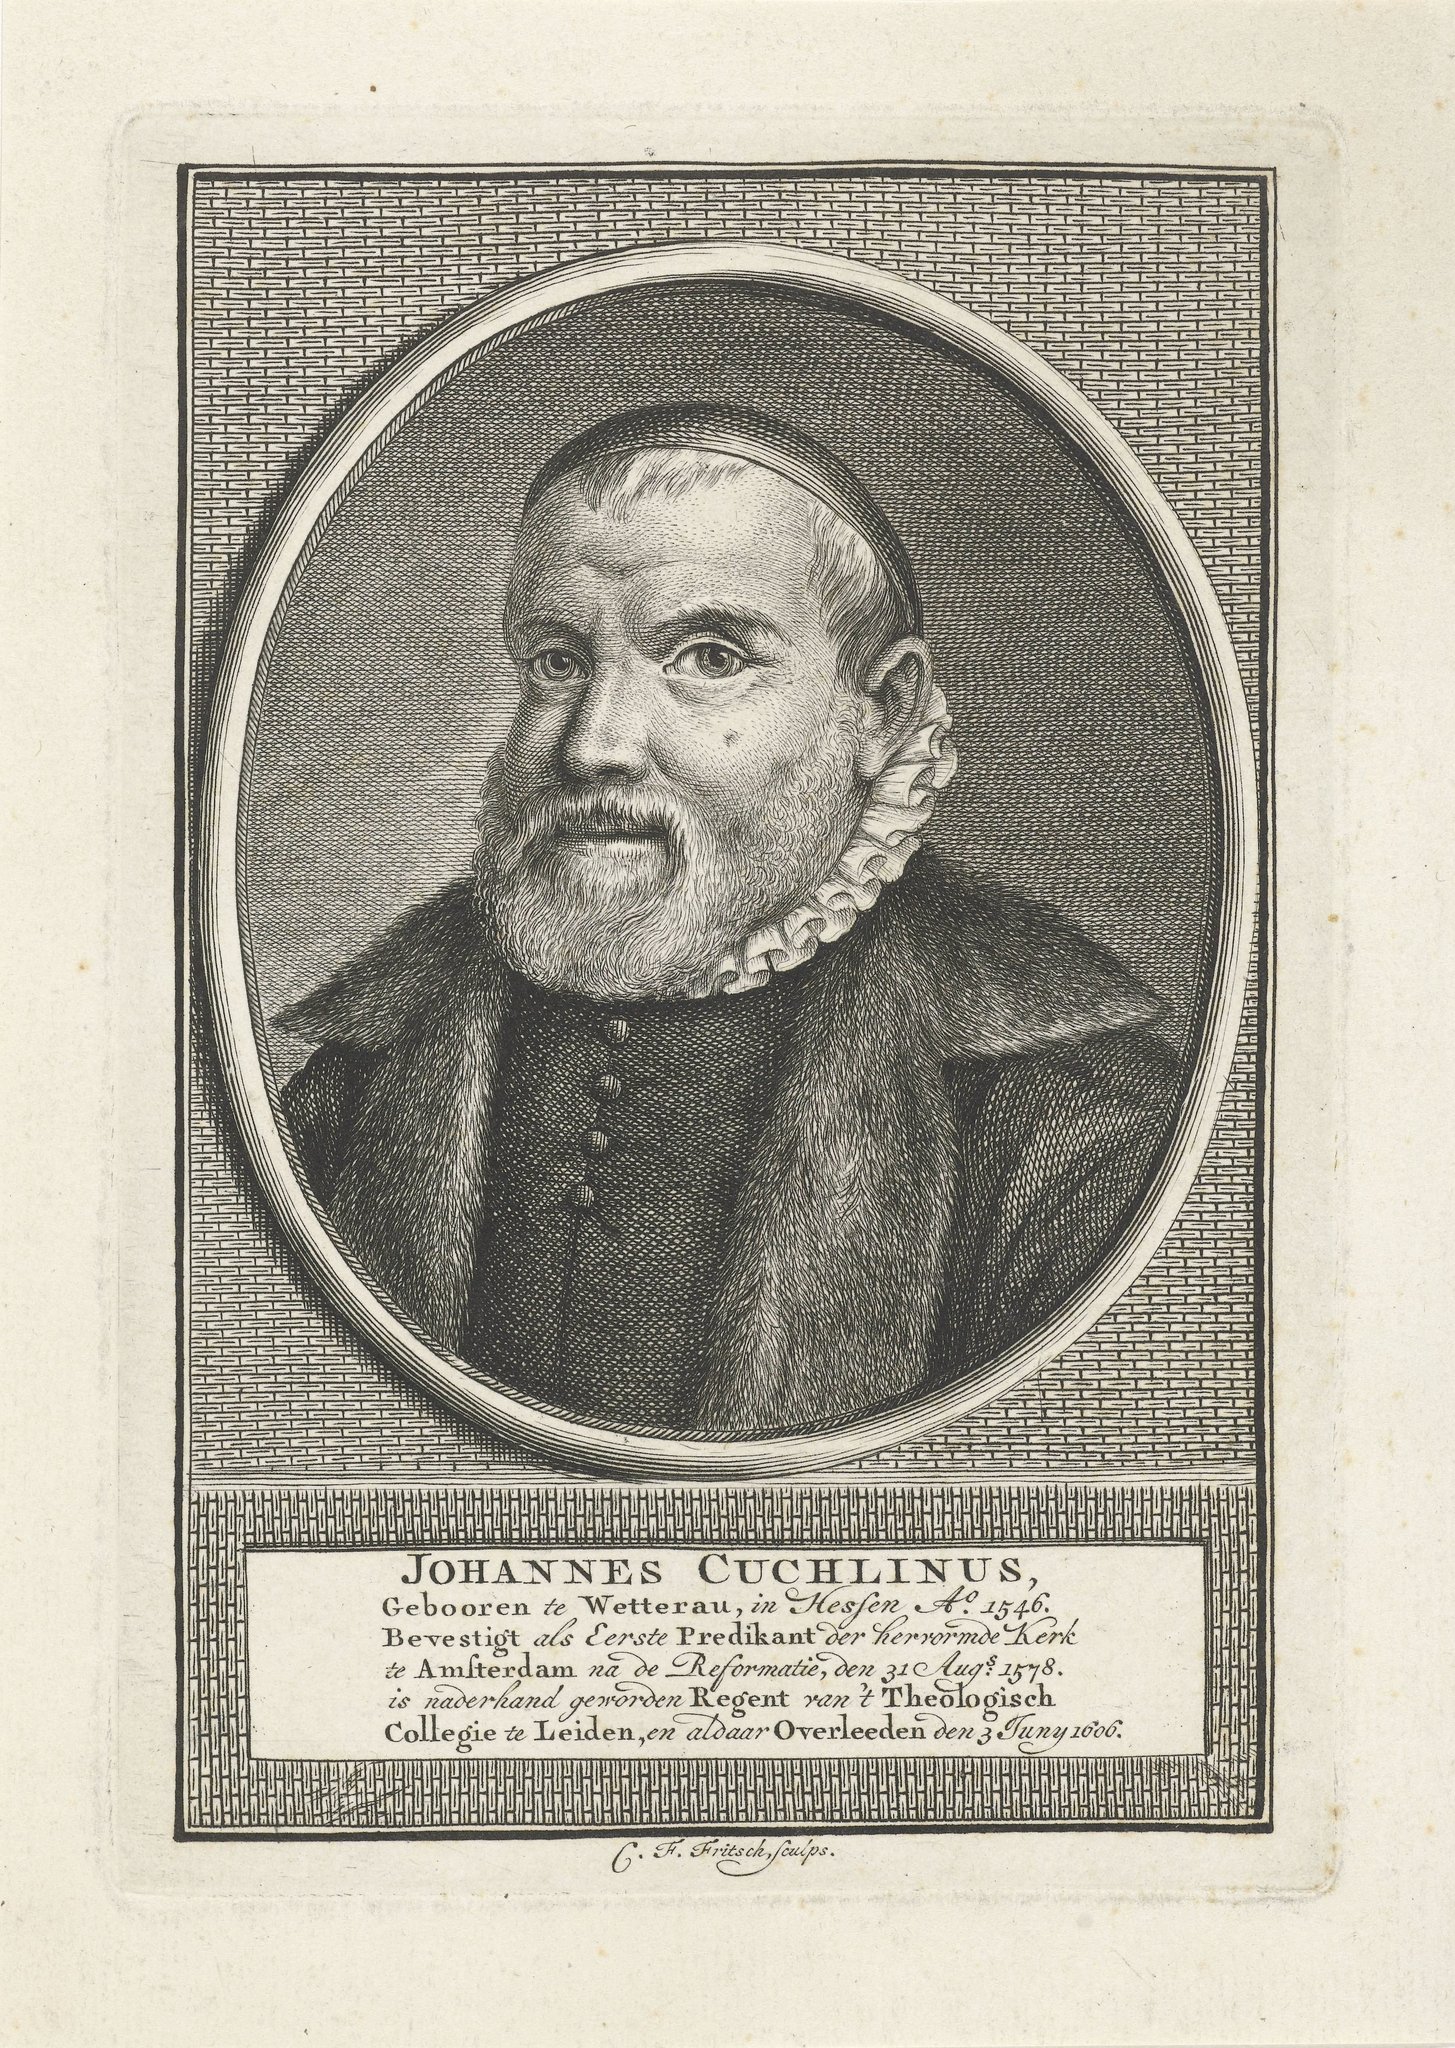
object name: print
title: Portret van Johannes Cuchlinus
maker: christian friedrich fritzsch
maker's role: print maker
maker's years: 1719-1774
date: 1719-1774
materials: paper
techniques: engraving, etching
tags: johannes cuchlinus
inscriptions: collector's mark: Lugt 2228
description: Portret in ovaal van predikant Johannes Cuchlinus, ten halven lijve naar links. Op het hoofd een kalot. Onder het ovaal een zesregelige tekst in het Nederlands.